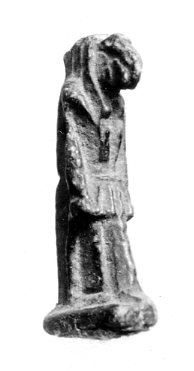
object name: amulet, thoth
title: Thoth amulet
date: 664-630 BCE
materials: faience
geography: egypt